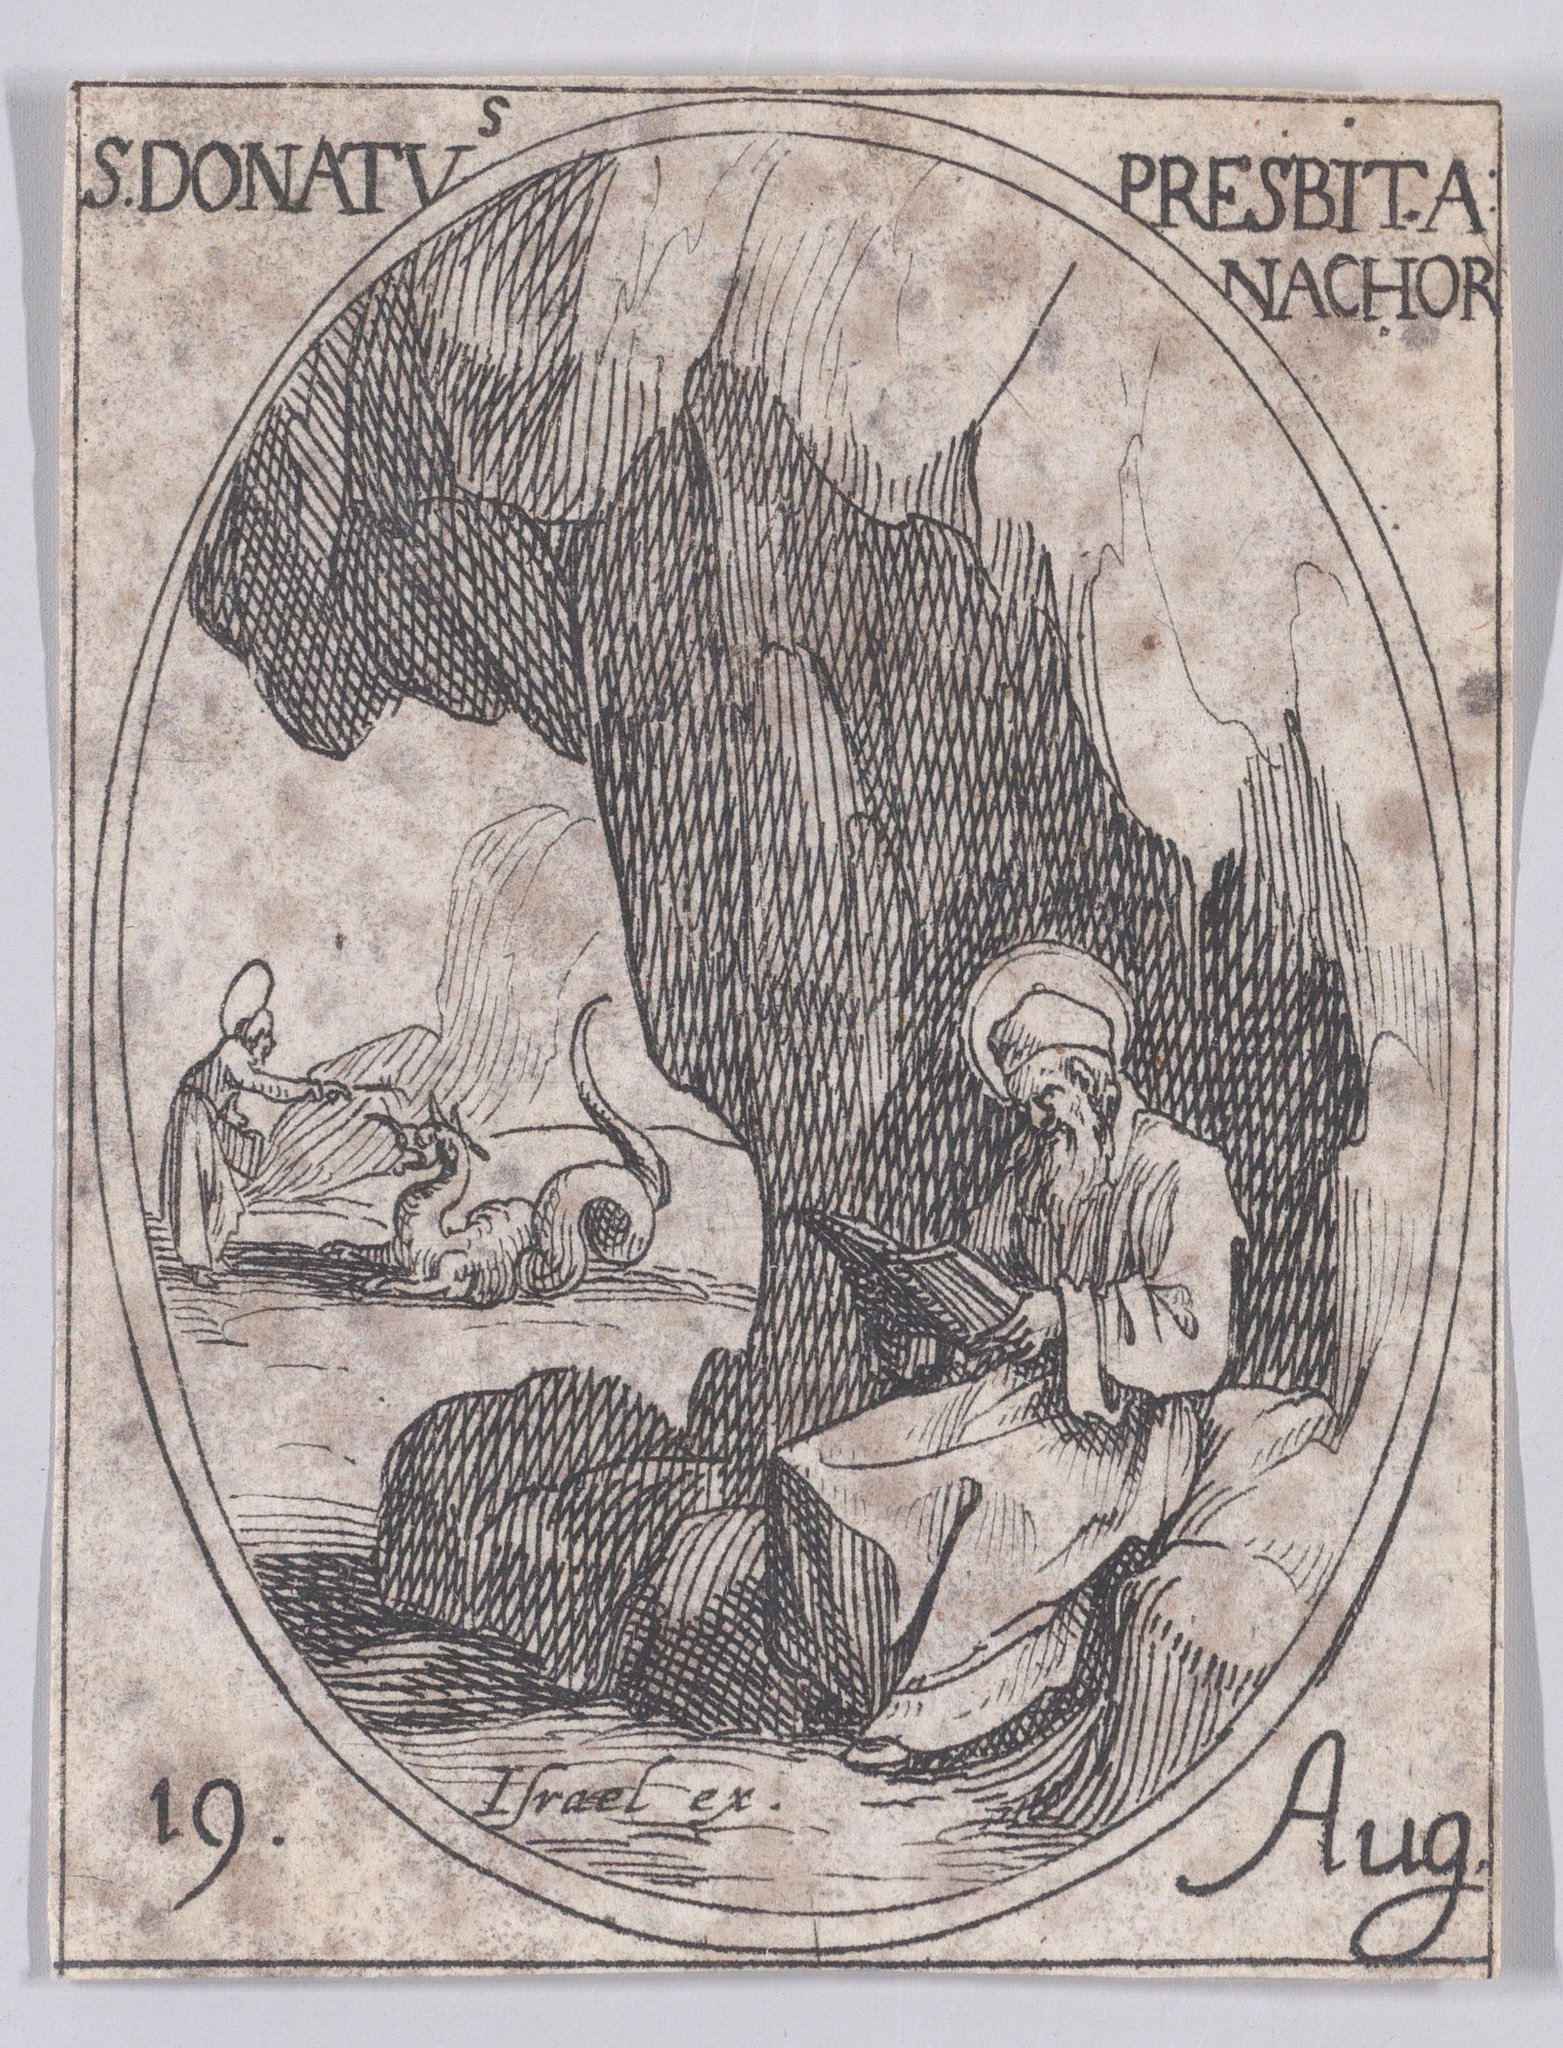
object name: print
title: S. Donat, prêtre, anachorète (St. Donatus, Priest and Anchorite), August 19th, from "Les Images De Tous Les Saincts et Saintes de L'Année" (Images of All of the Saints and Religious Events of the Year)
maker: jacques callot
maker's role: artist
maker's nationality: french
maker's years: 1592-1635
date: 1636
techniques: etching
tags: men,reading,dragons,saints